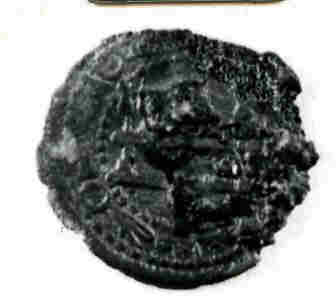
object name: coin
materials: copper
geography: iran